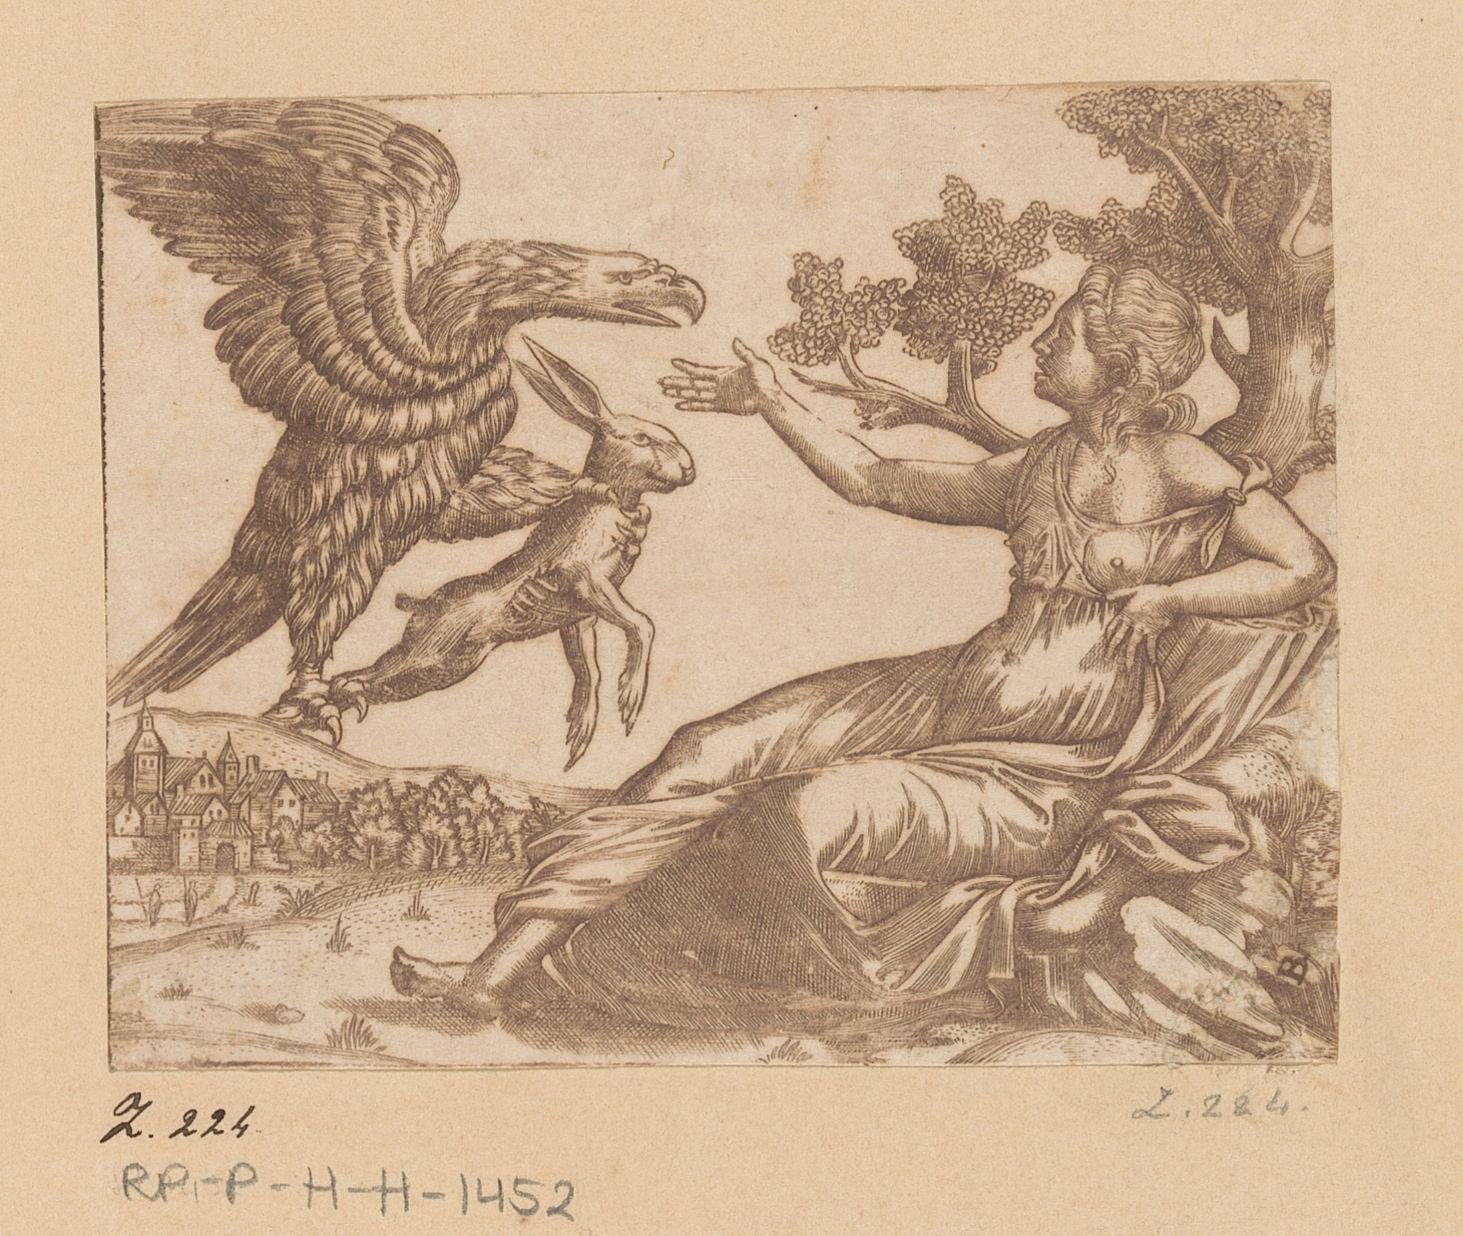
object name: print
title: Adelaar brengt jonge vrouw een haas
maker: monogrammist b (italië)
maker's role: print maker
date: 1600-1699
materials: paper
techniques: printing, engraving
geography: italy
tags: predatory birds: eagle, rodents: hare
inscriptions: collector's mark: Lugt 11, collector's mark: ‘Hinloopen’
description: Een landschap met een jonge vrouw leunend tegen een boom. Een adelaar komt aangevlogen met een haas voor de vrouw.